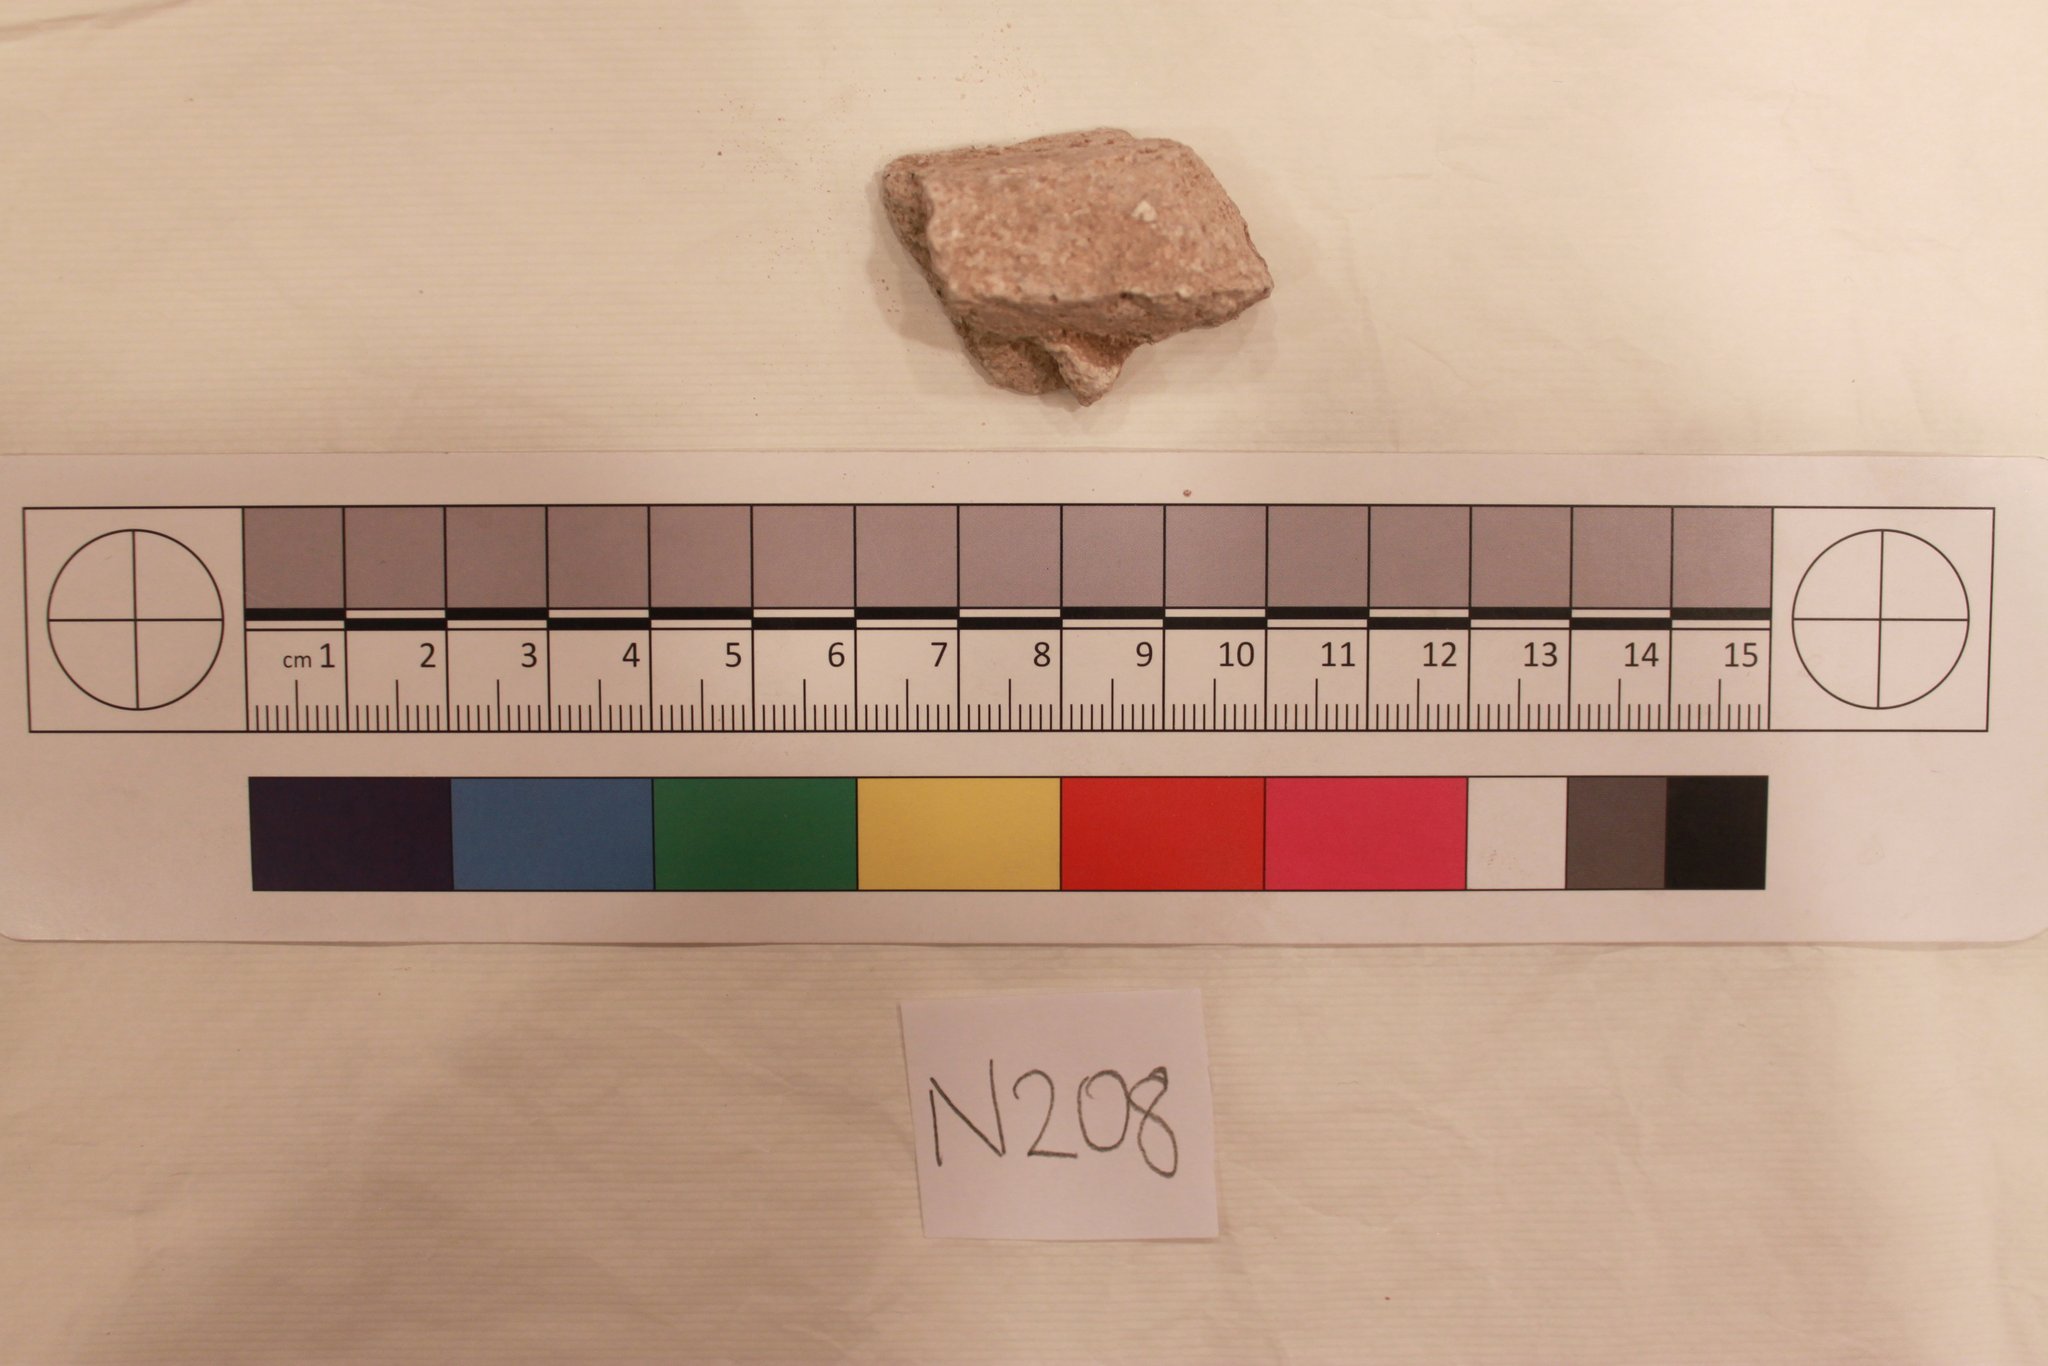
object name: fragment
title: Stucco Fragment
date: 701-1200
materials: plaster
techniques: carving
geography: iran